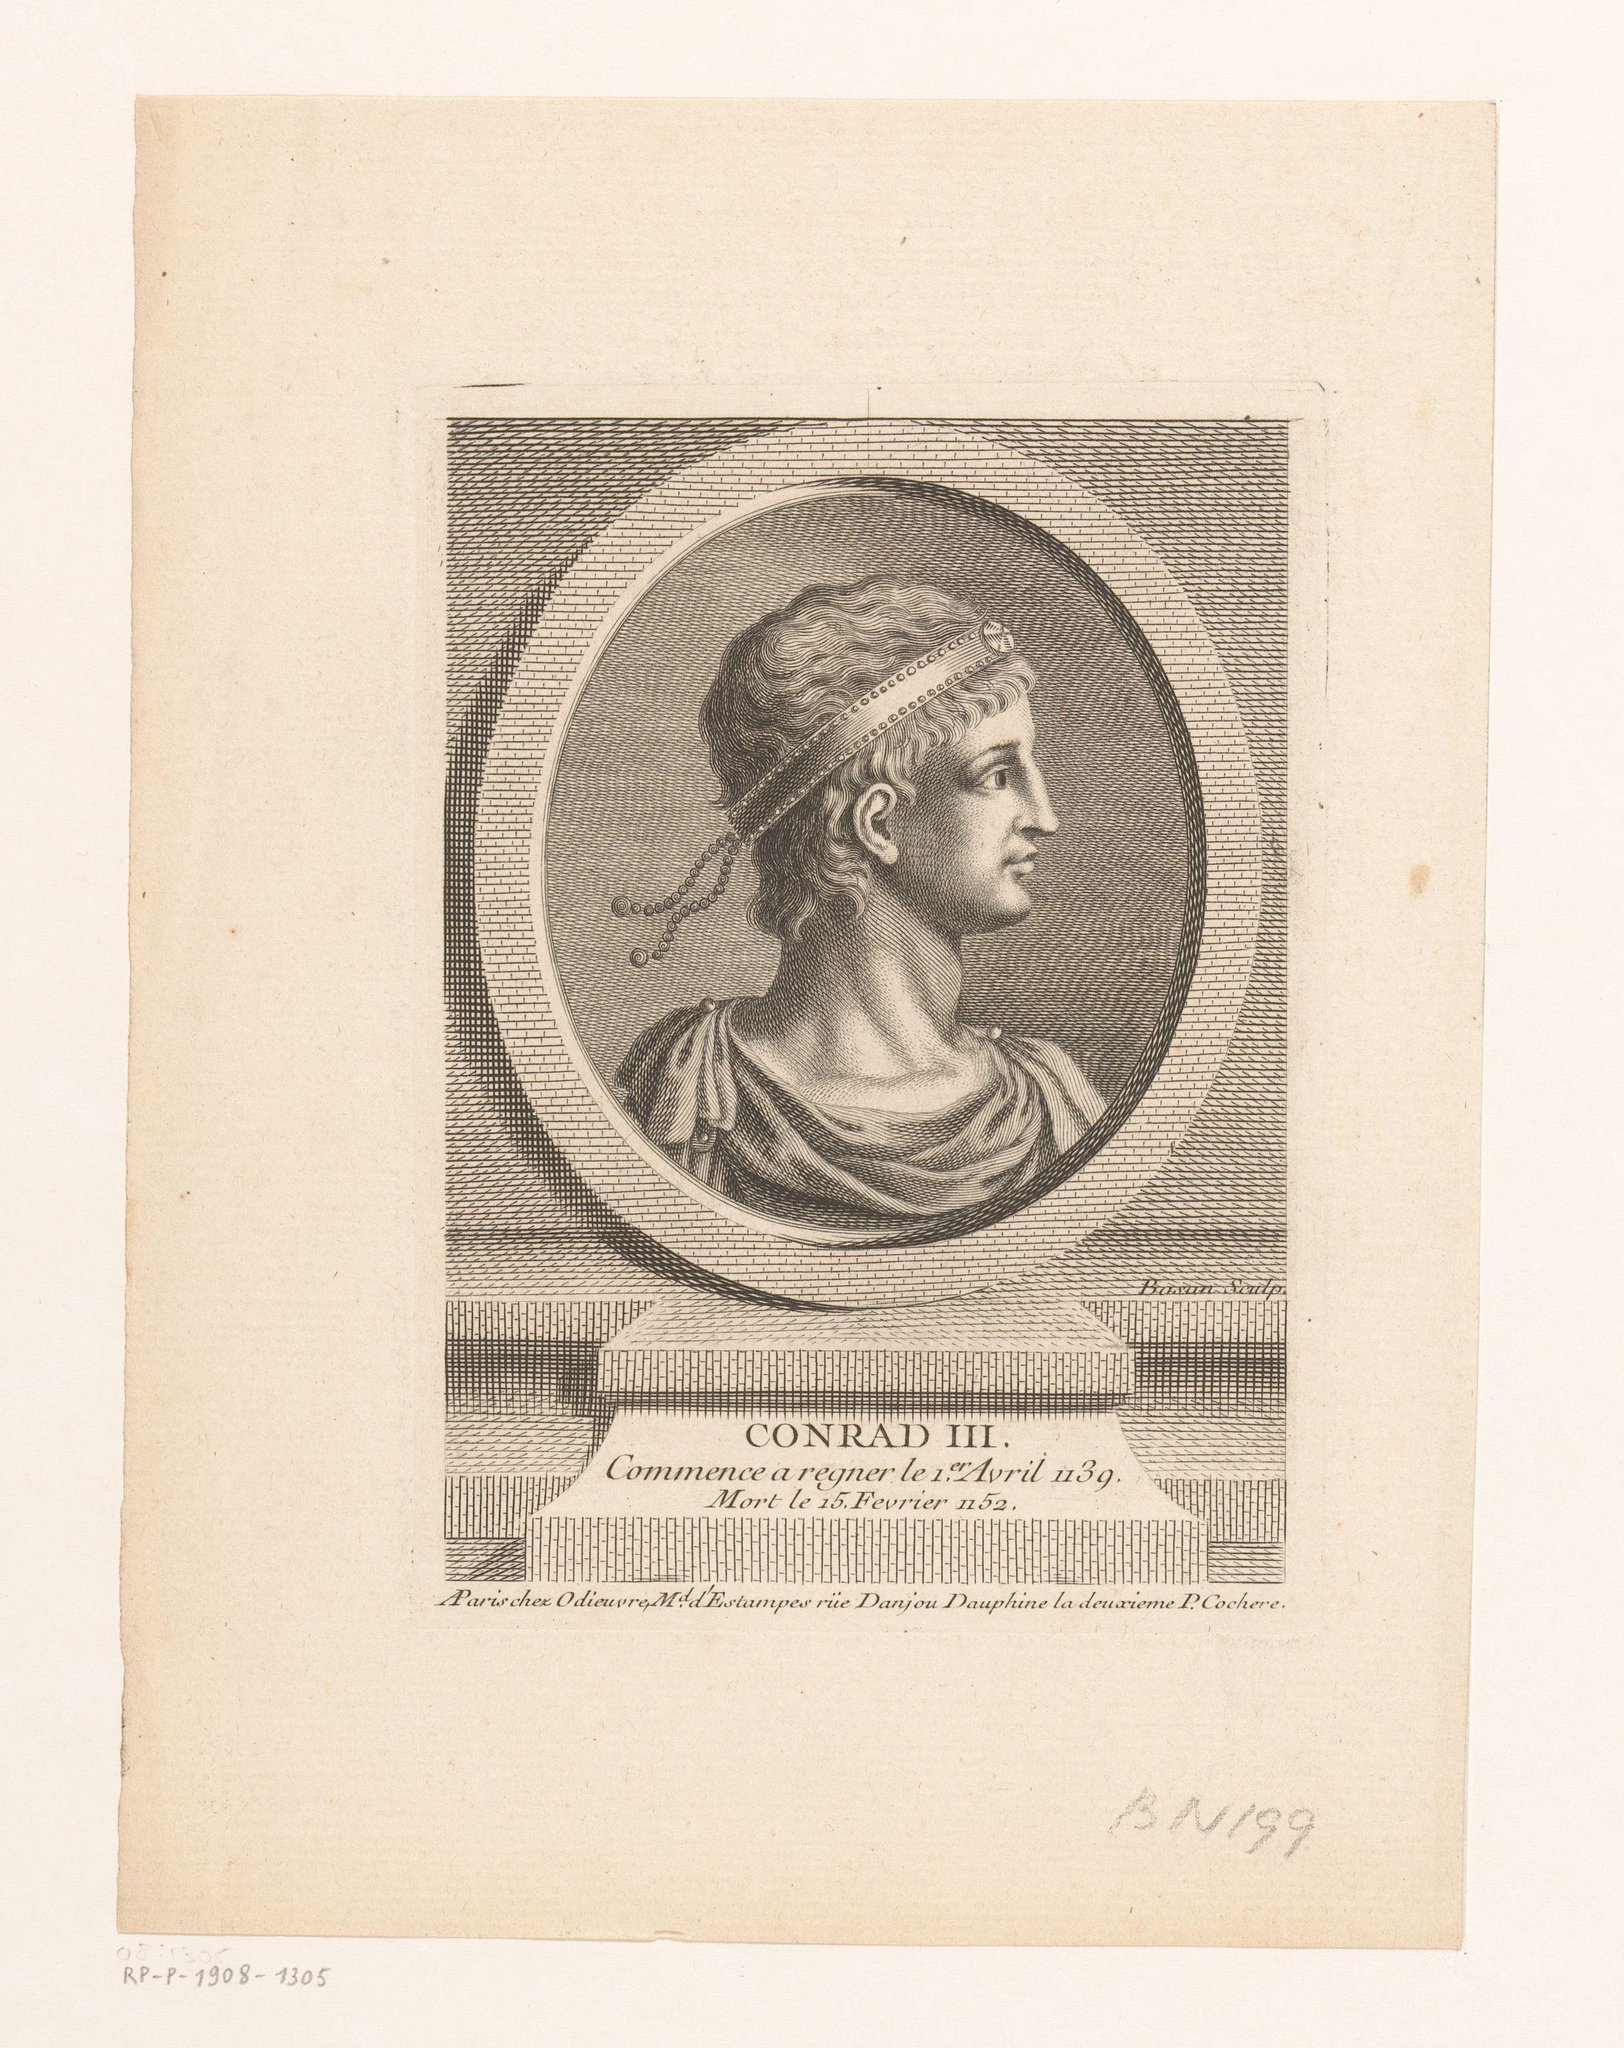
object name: print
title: Portret van Koenraad III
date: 1733-1756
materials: paper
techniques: engraving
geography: paris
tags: ornament ~ medallion, historical persons, ruler, sovereign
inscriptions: collector's mark: Lugt 2228